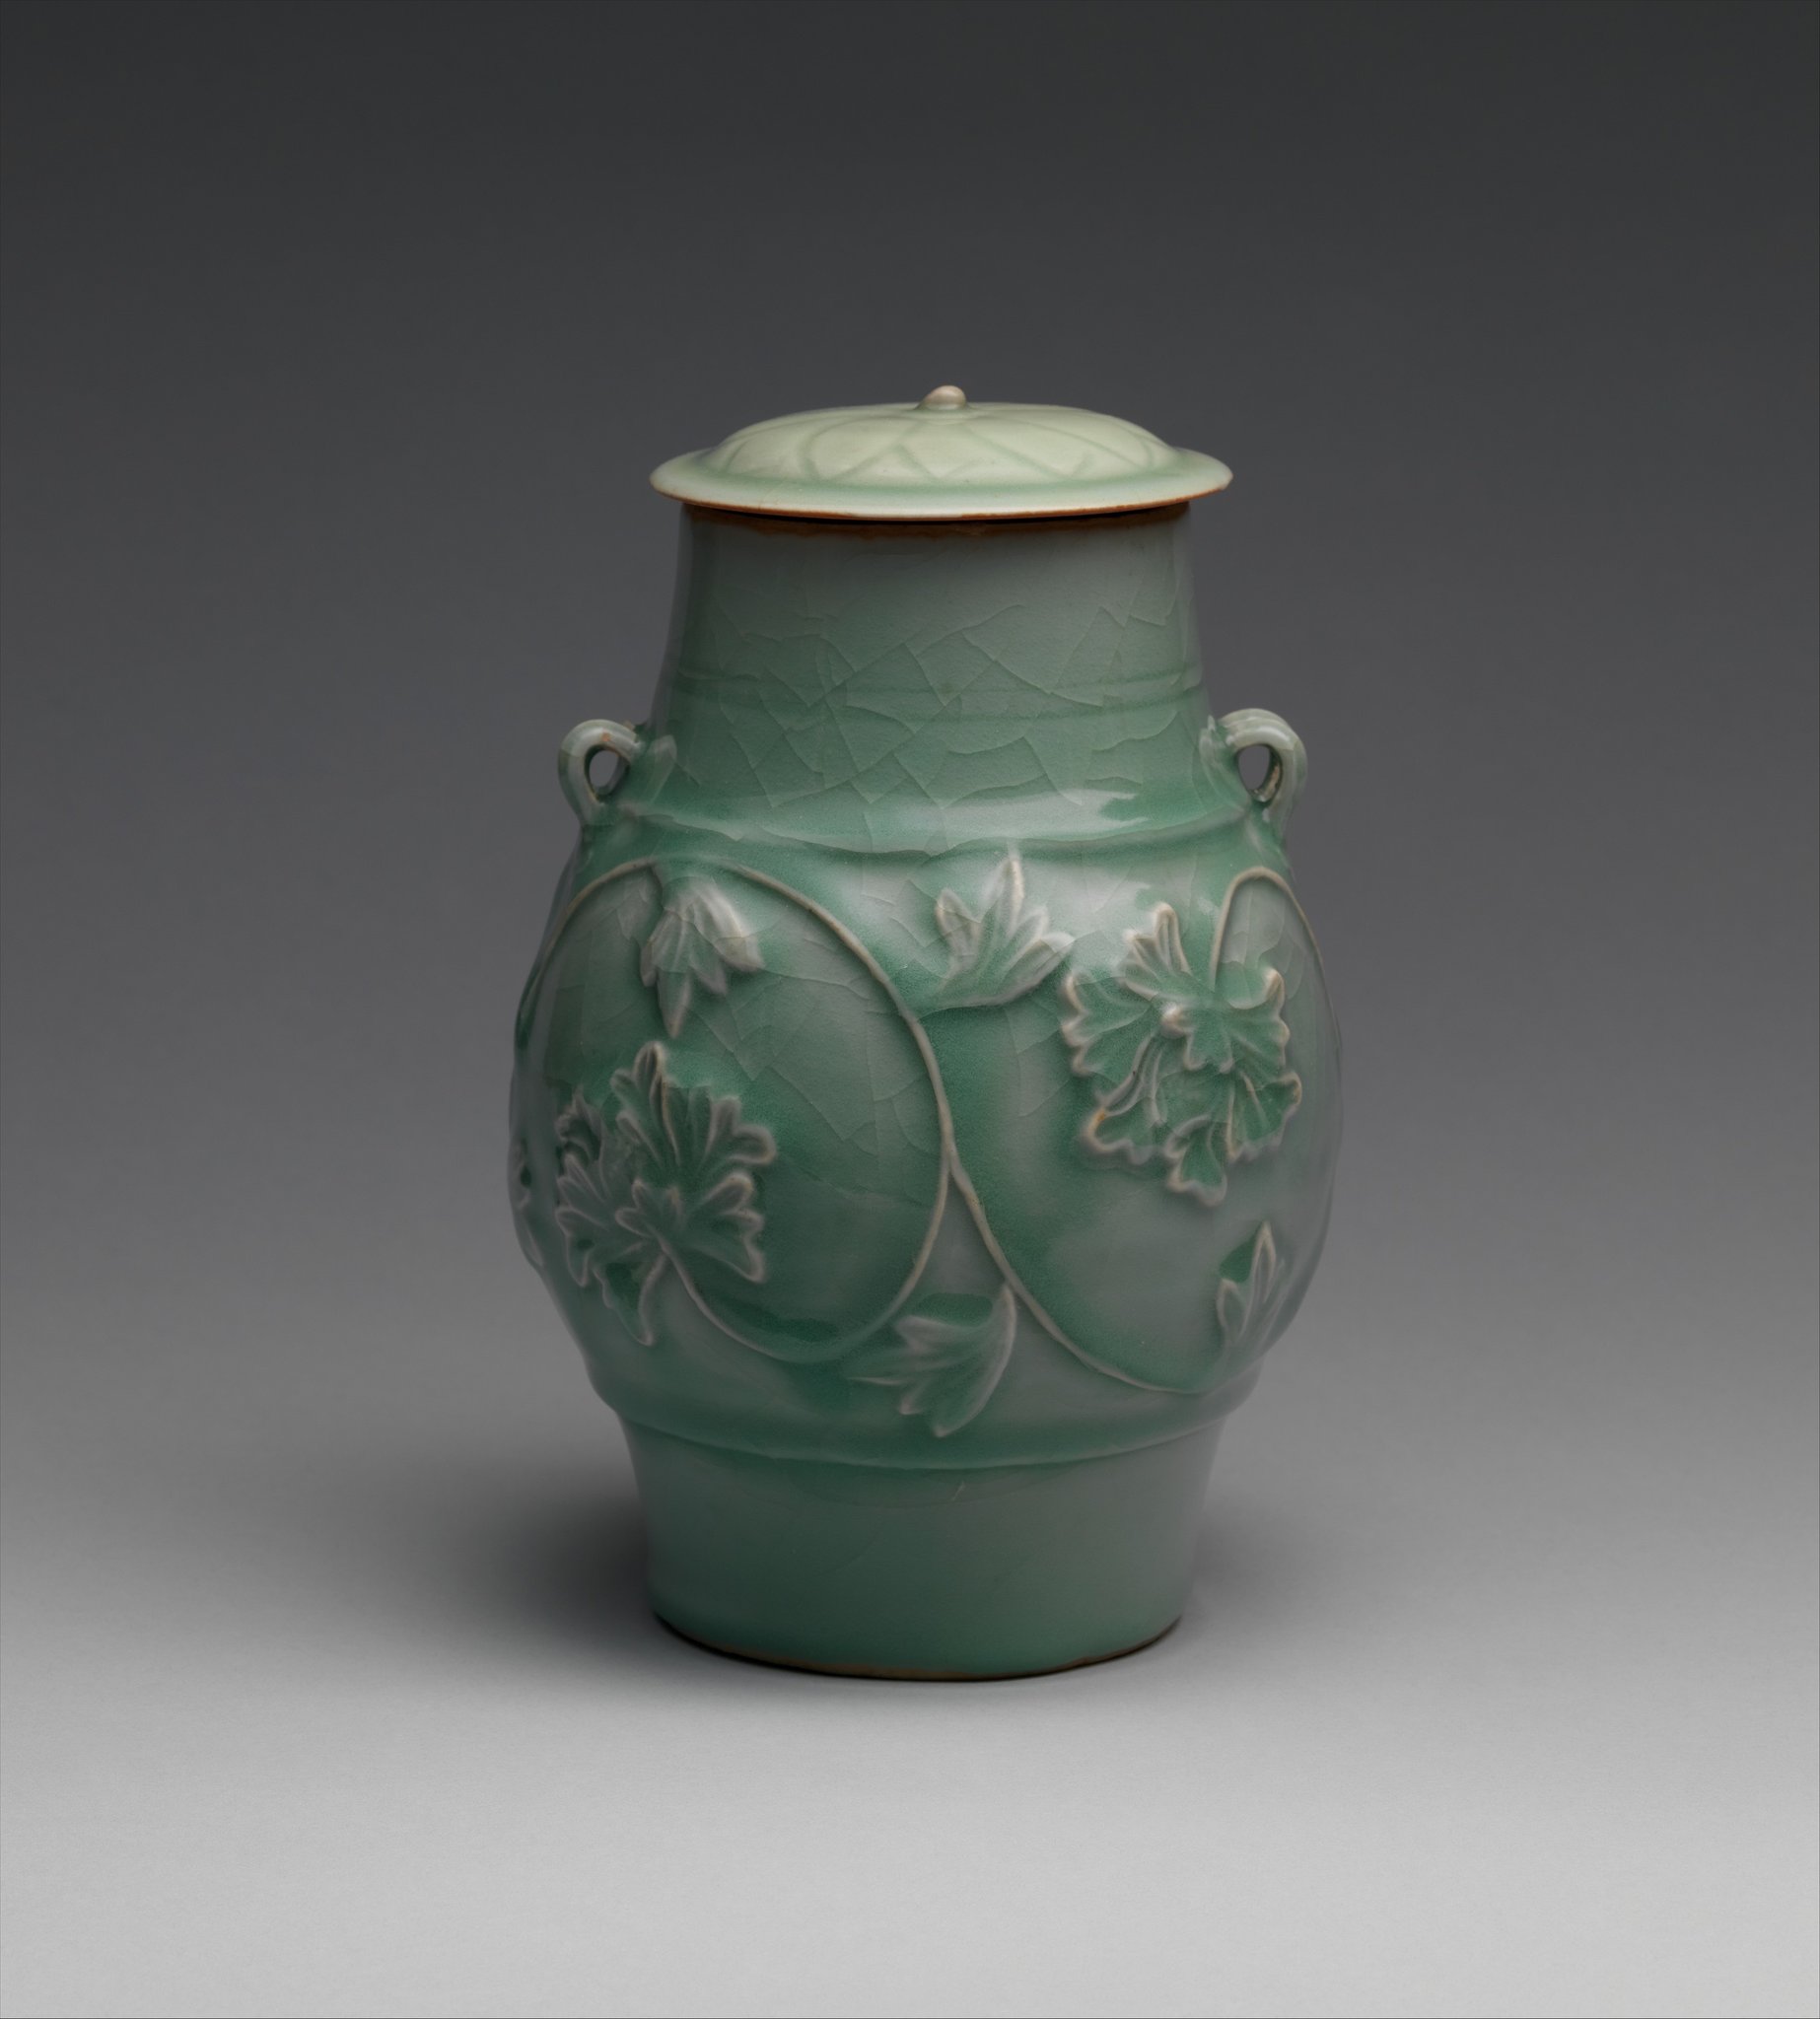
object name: jar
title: Jar with peony scroll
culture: chinese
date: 1301-1400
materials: ceramic glaze, glaze, porcelain